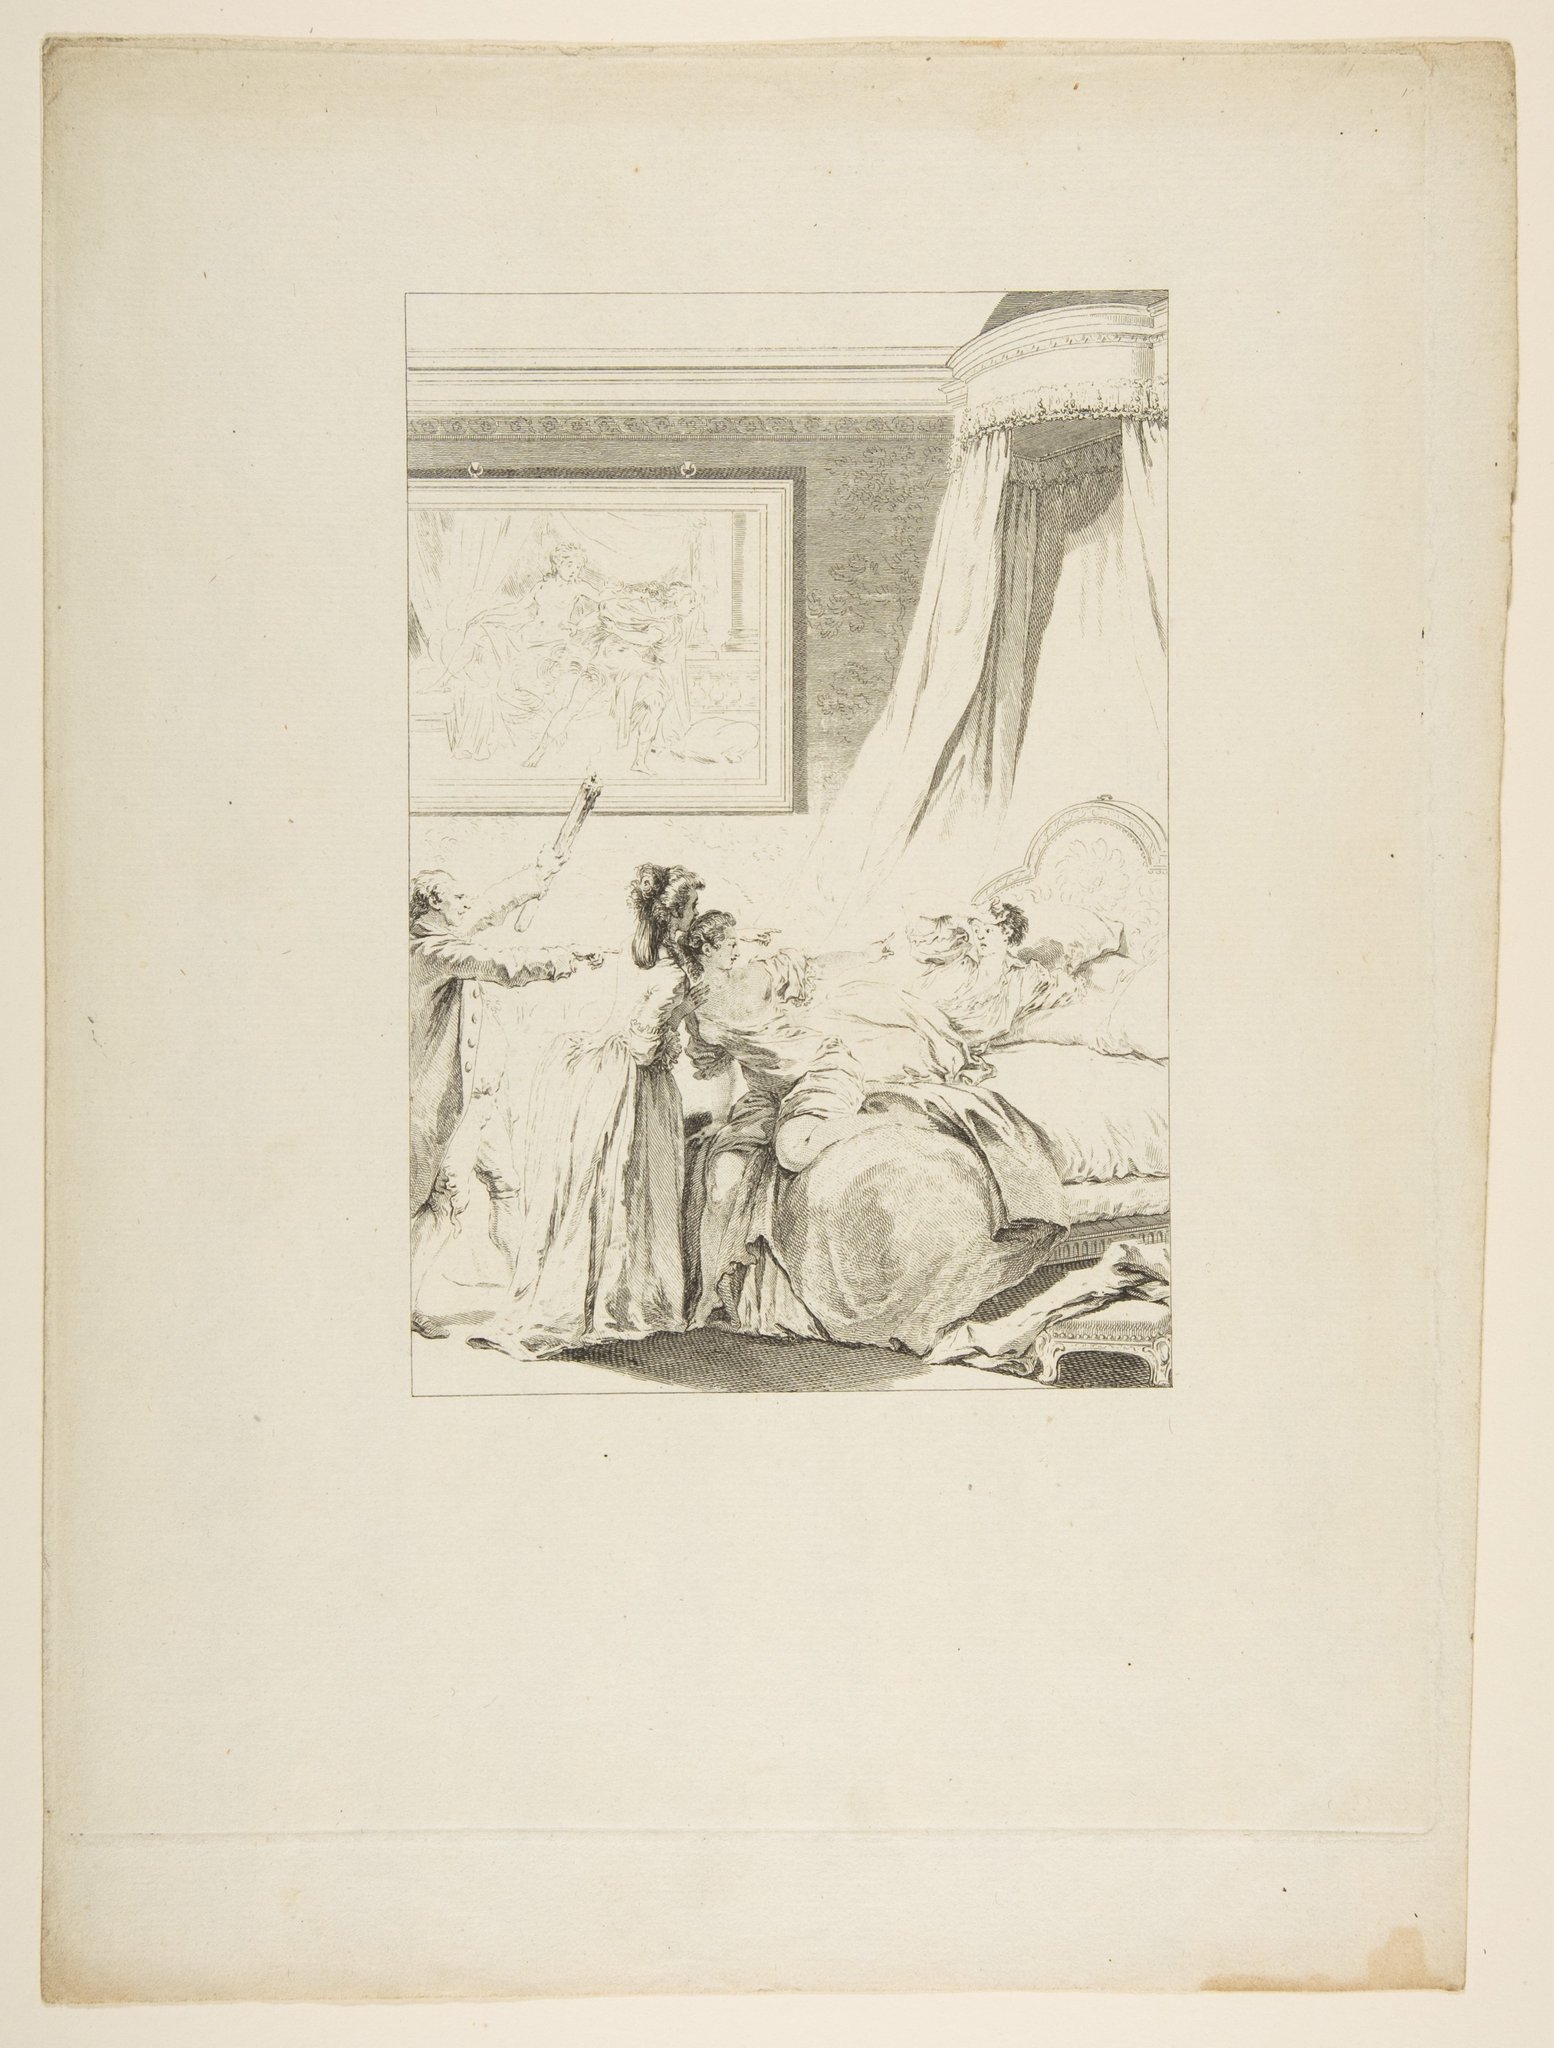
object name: print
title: Le Gascon puni, from "Contes et nouvelles en vers par Jean de La Fontaine. A Paris, de l'imprimerie de P. Didot, l'an III de la République, 1795"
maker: louis michel halbou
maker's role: artist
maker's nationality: french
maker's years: 1730-1809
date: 1795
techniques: etching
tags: men,women,beds